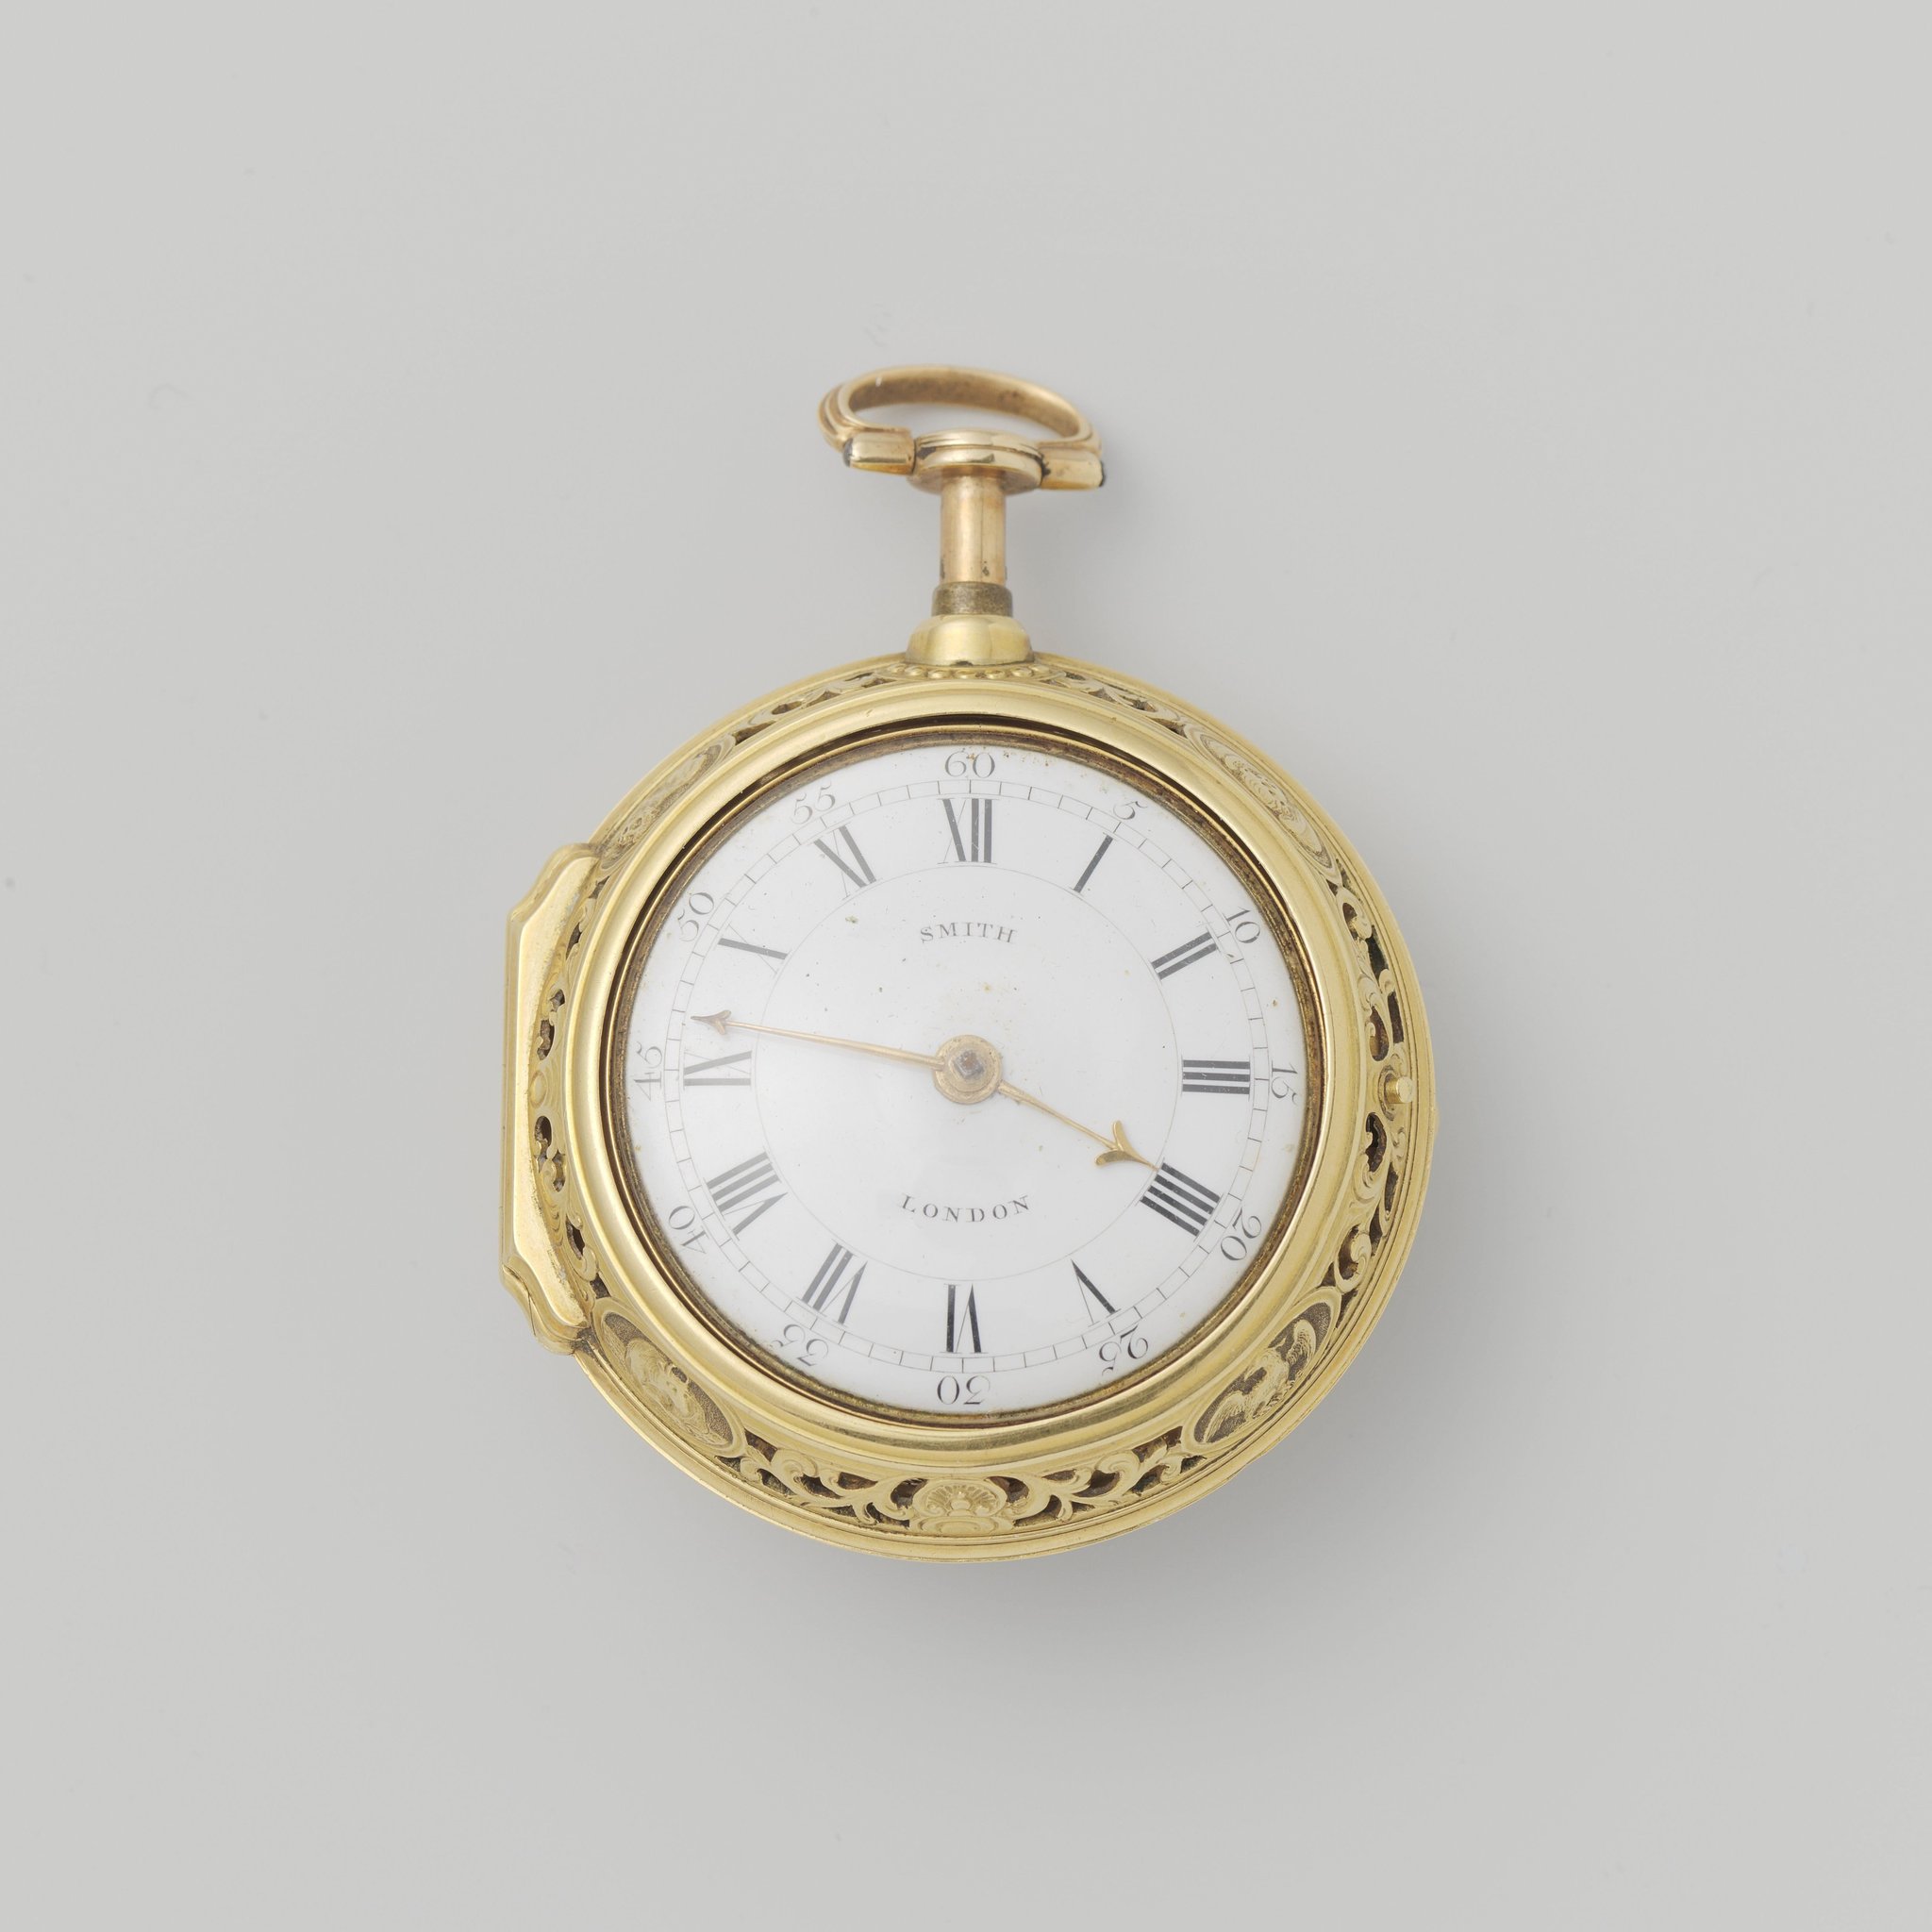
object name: pocket watch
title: Watch with a Chased Scene of the Wedding at Cana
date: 1783-1785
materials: gold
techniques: metalworking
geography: amsterdam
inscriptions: inscription: ‘N.S. 1783’, town mark: ‘Amsterdam’, maker's mark: ‘HLP’, signature: ‘Jos Smith London’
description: Rond zakhorloge met gegraveerde en geciseleerde gouden kast en gedreven gouden overkast. De laatste versierd met de voorstelling van de bruiloft te Kana.